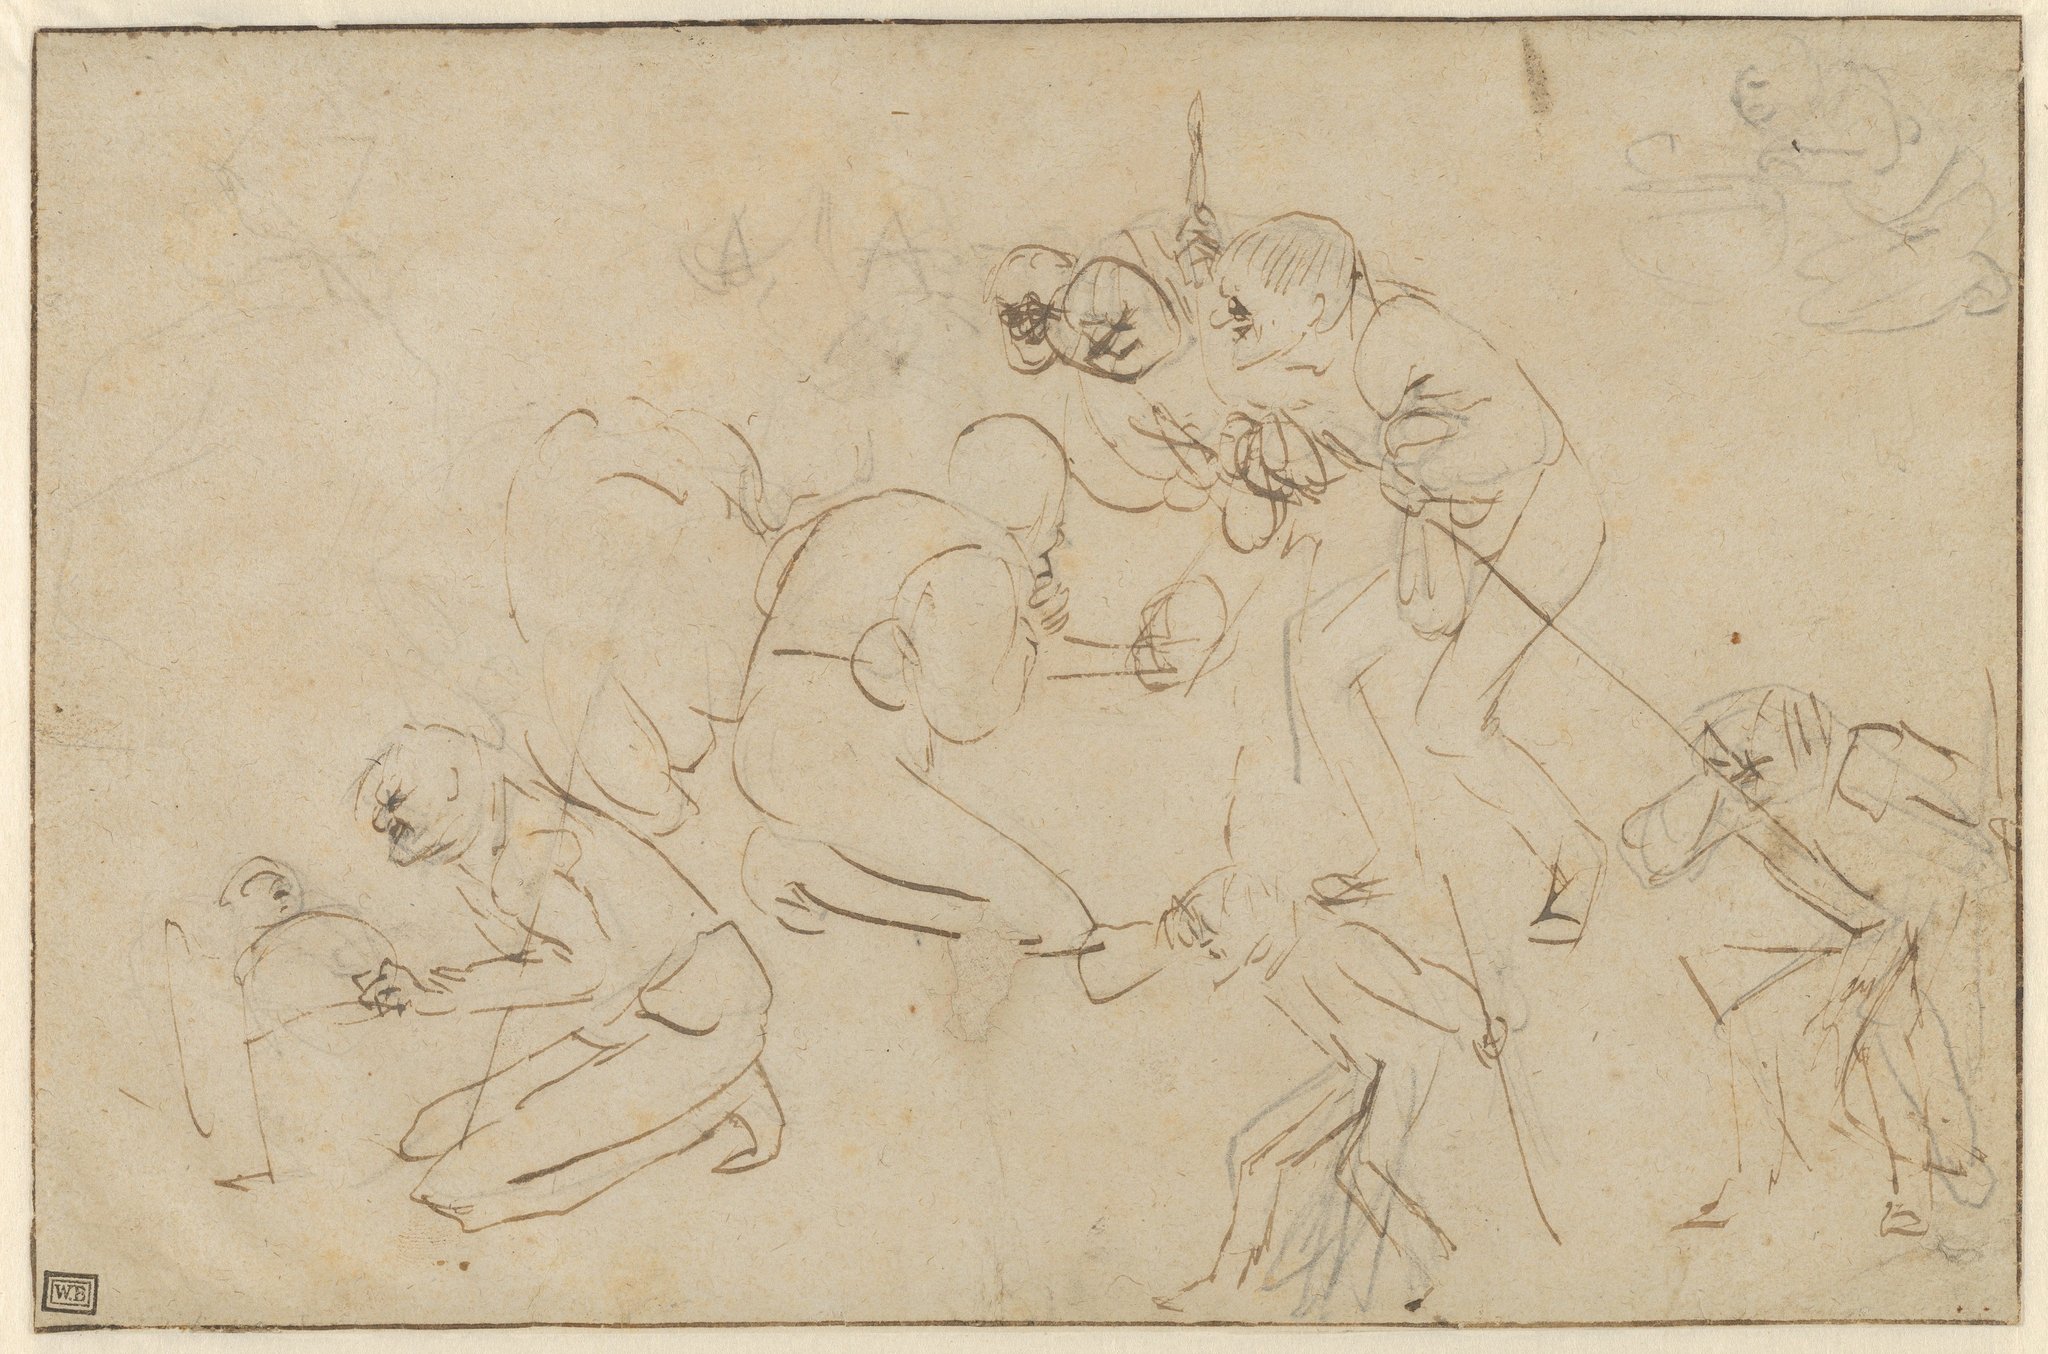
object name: drawing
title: Studies for an Adoration of the Shepherds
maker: adriaen brouwer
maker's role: artist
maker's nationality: flemish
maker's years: 1605-1638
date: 1601-1633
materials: chalk, ink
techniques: pen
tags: adoration of the shepherds